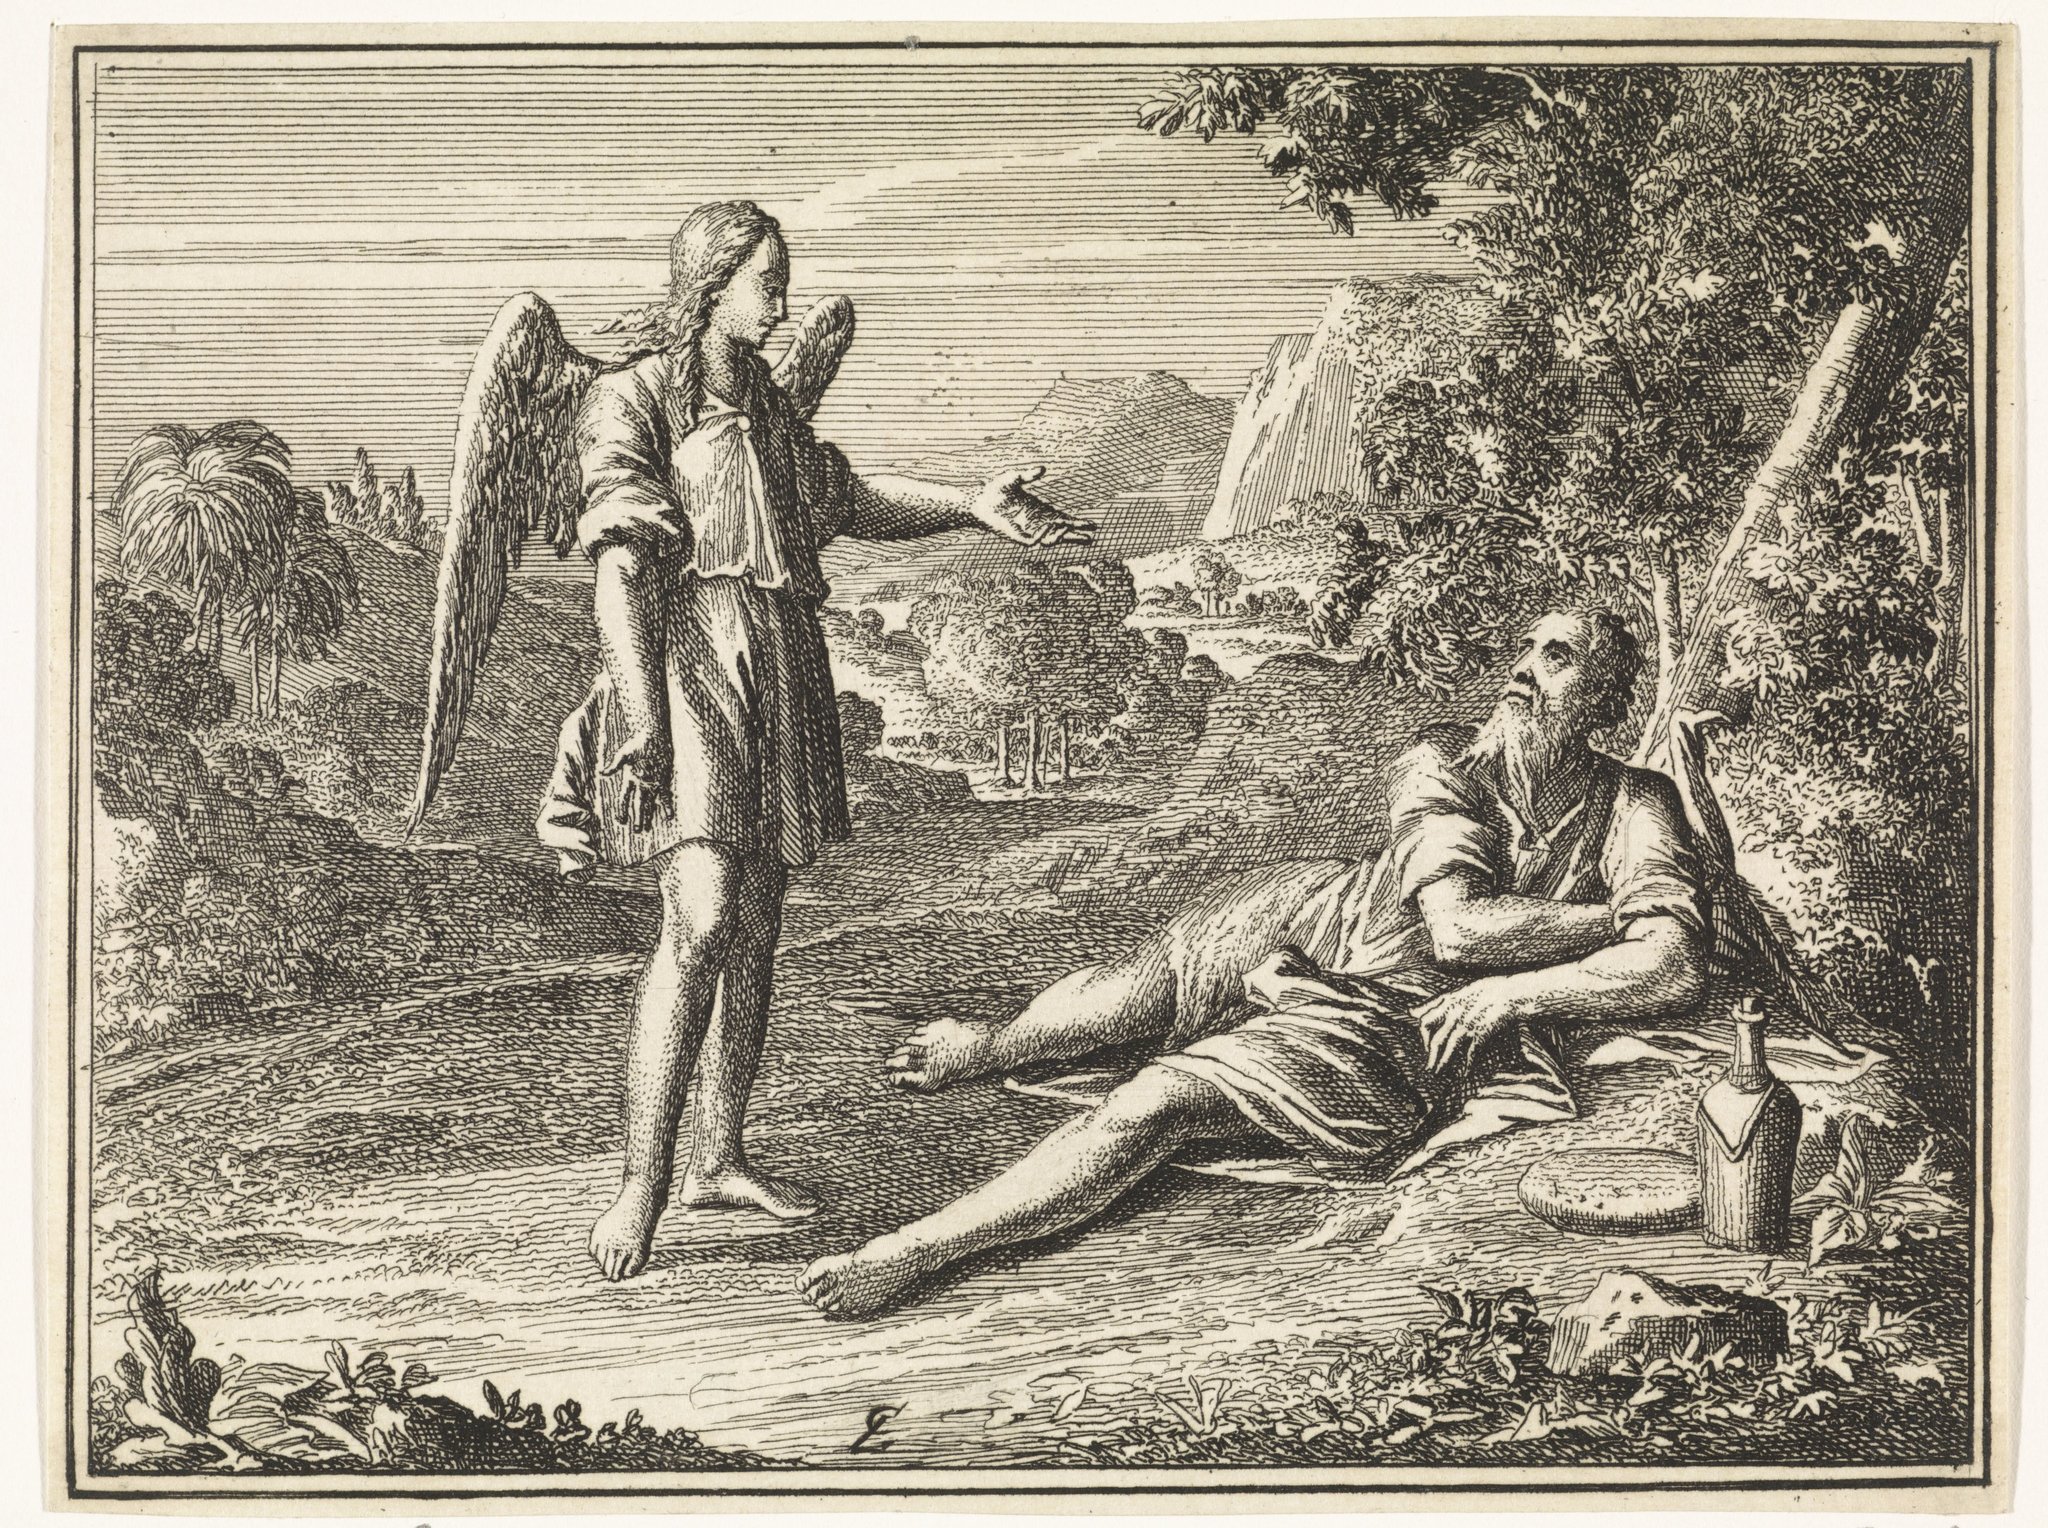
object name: print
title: Elia bezocht door een engel in de woestijn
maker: jan luyken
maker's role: draughtsman, print maker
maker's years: 1649-1712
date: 1712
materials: paper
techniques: etching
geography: amsterdam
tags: an angel wakes elijah; a loaf of bread and a jar of water are usually at elijah's head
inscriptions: number: ‘137’, collector's mark: Lugt 2228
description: Illustratie uit: Luyken, Jan. De schriftuurlyke geschiedenissen en gelykenissen van het Oude en Nieuwe Verbond, 2 delen. Amsterdam: Wed. Pieter Arentsz II en Cornelis van der Sys, 1712, dl. I.